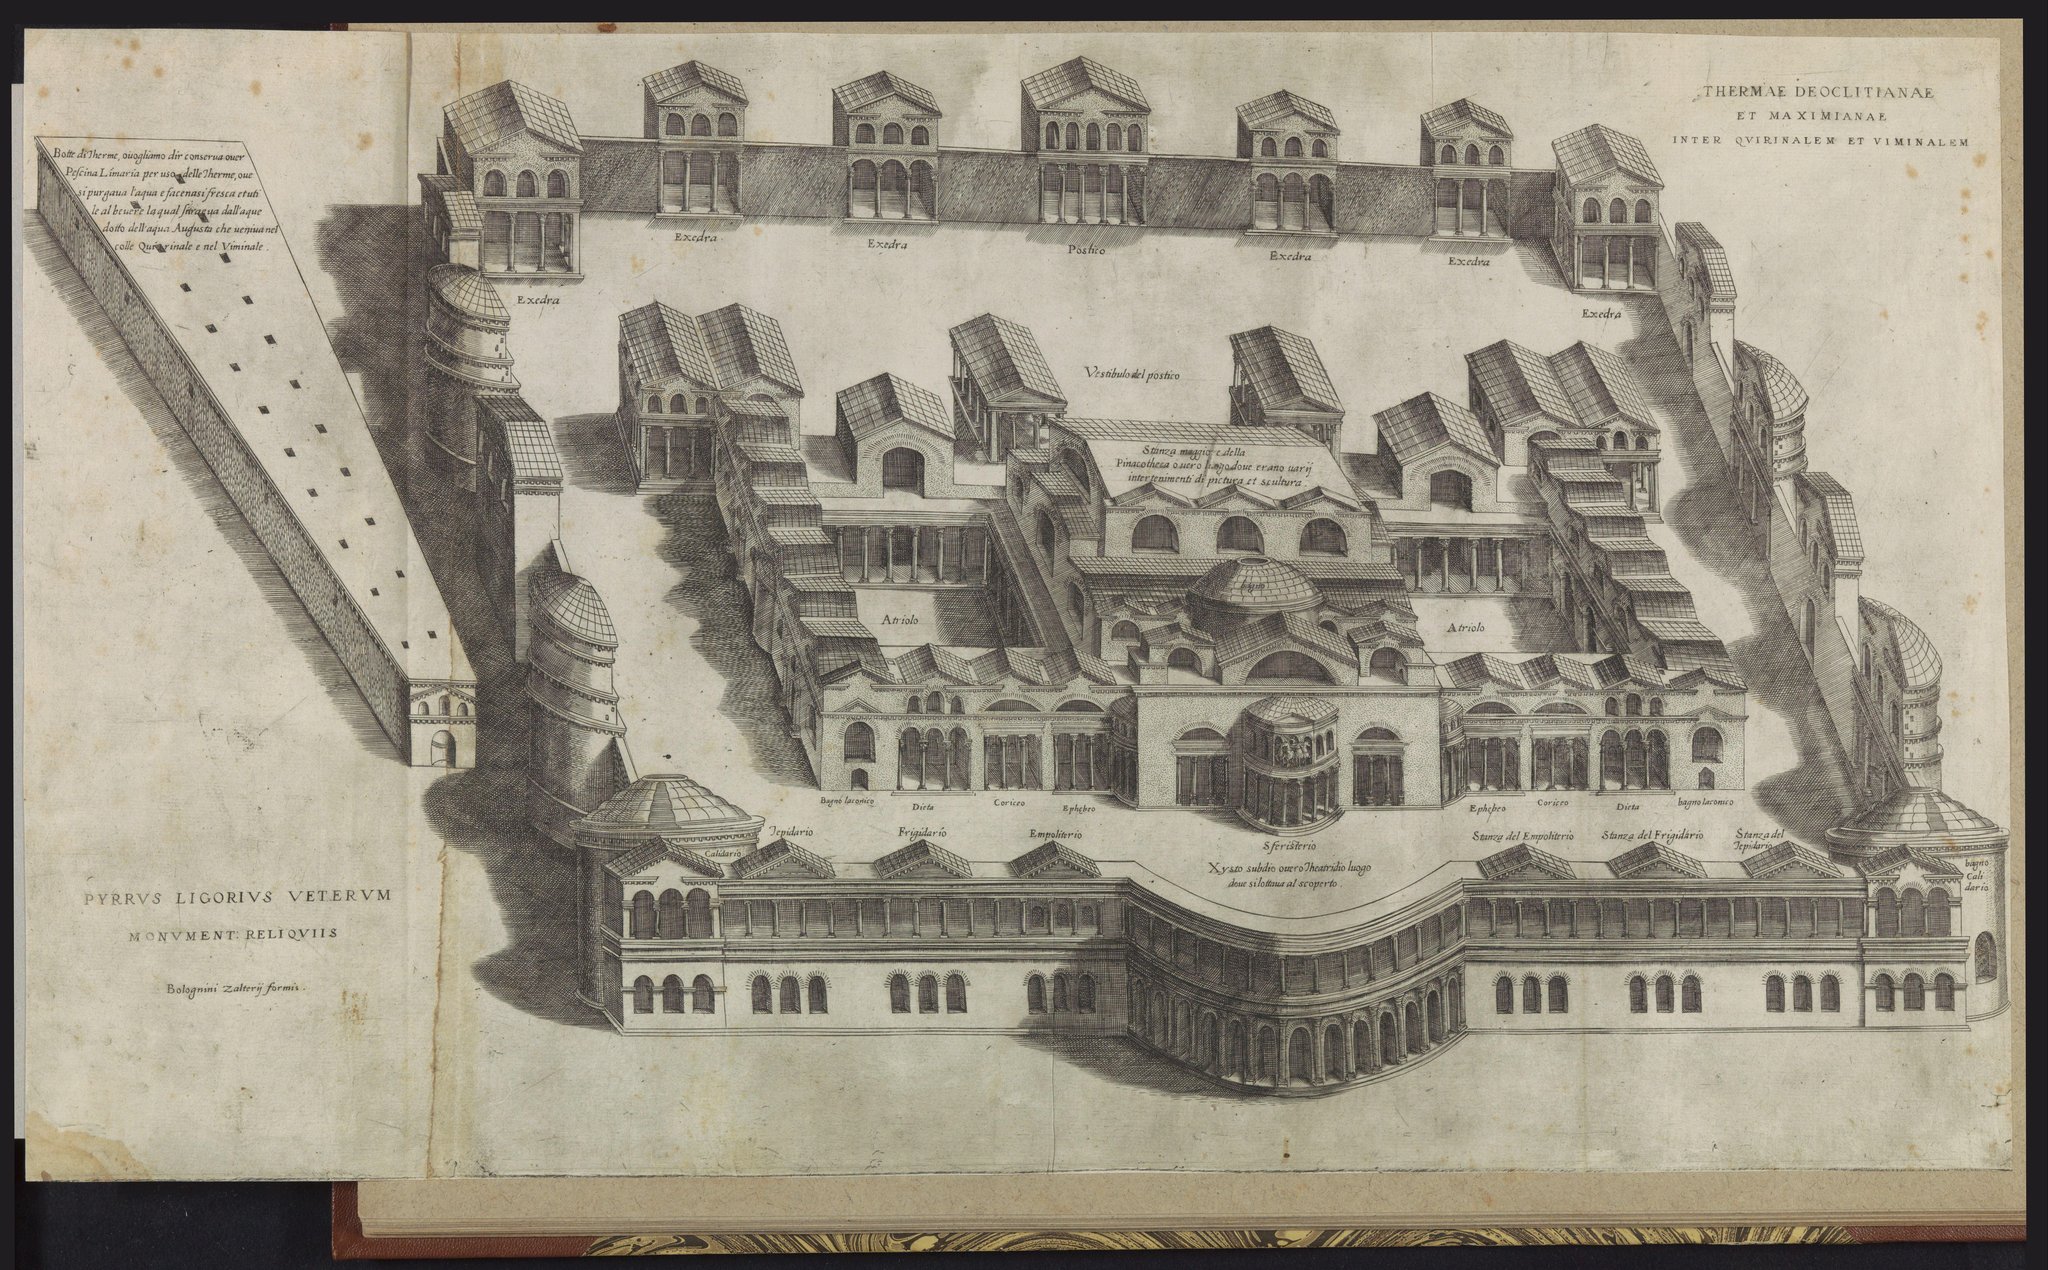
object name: album leaf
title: Speculum Romanae Magnificentiae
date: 1560-1580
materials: paper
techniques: engraving, etching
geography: italy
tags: public baths, representation of real building (either existing or having existed)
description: Deze prent behoort tot het prentcorpus dat bekend staat als de ‘Speculum Romanae Magnificentiae’ (‘Spiegel van Romeinse pracht’). Dit corpus, bestaande uit prenten met voorstellingen van kunstwerken en gebouwen uit het antieke en het moderne Rome, vond zijn oorsprong bij uitgevers Antonio Salamanca en Antonio Lafreri. Deze twee buitenlandse uitgevers bundelden hun krachten te Rome in de periode 1553-1563. Hun prenten werden al snel razend populair bij toeristen en verzamelaars, die de prenten individueel of in grote groepen aanschaften. Grote groepen Speculum-prenten werden vaak op aanvraag samengebonden in albums. Er zijn verschillende Speculum-albums overgeleverd die allemaal verschillen van inhoud. Tussen 1573 en 1577 gaf Antonio Lafreri een speciale titelpagina uit (met de titel ‘Speculum Romanae Magnificentiae’) die mensen voor hun verzamelingen konden voegen. Het overlijden van Lafreri in 1577 betekende niet het einde van het corpus. Een groot deel van de koperplaten ging over op Claudio en Stefano Duchetti. De rest raakte verspreid over verschillende andere uitgevers. De populariteit van de Speculum-prenten wist nog geruime periode uitgevers te inspireren tot het laten maken van kopieën en het toevoegen van nieuwe prenten aan het corpus.